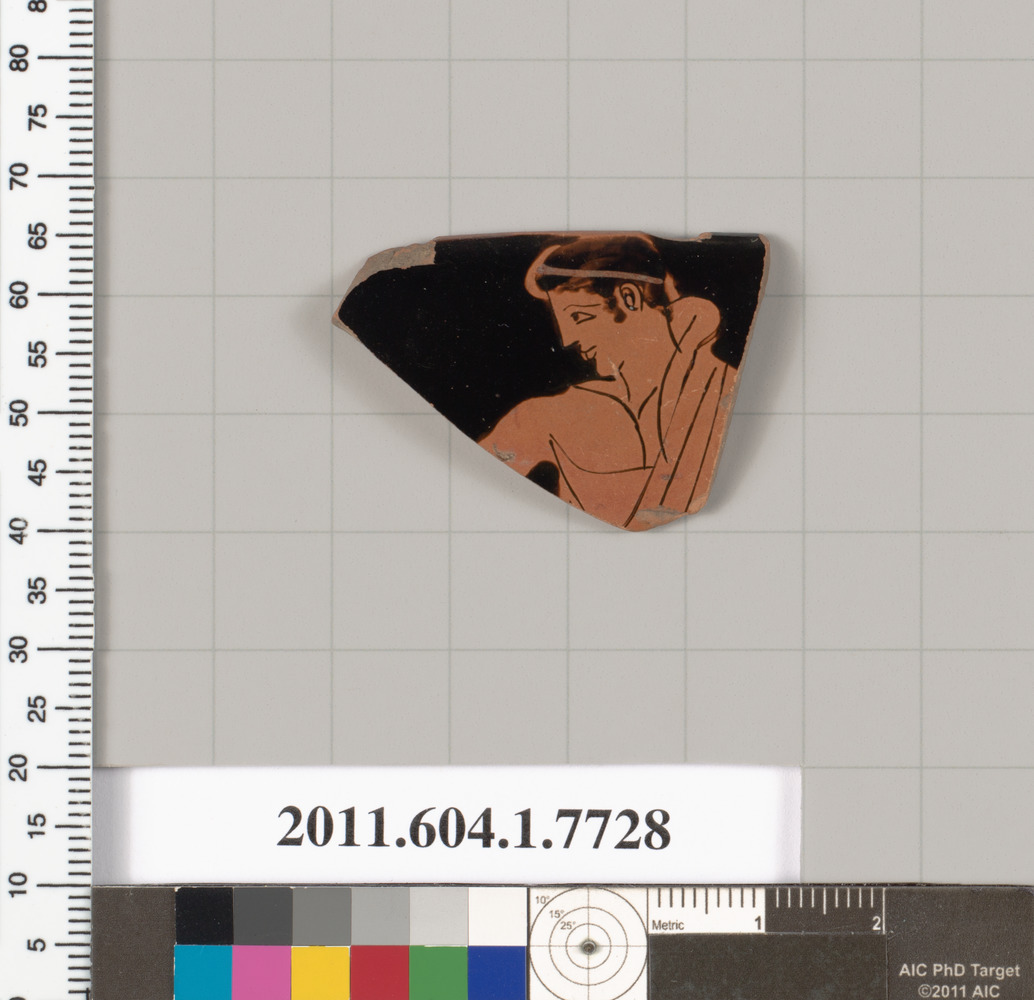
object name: kylix fragment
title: Terracotta rim fragment of a kylix (drinking cup)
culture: greek, attic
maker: orleans painter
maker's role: artist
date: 475-451 BCE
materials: terracotta